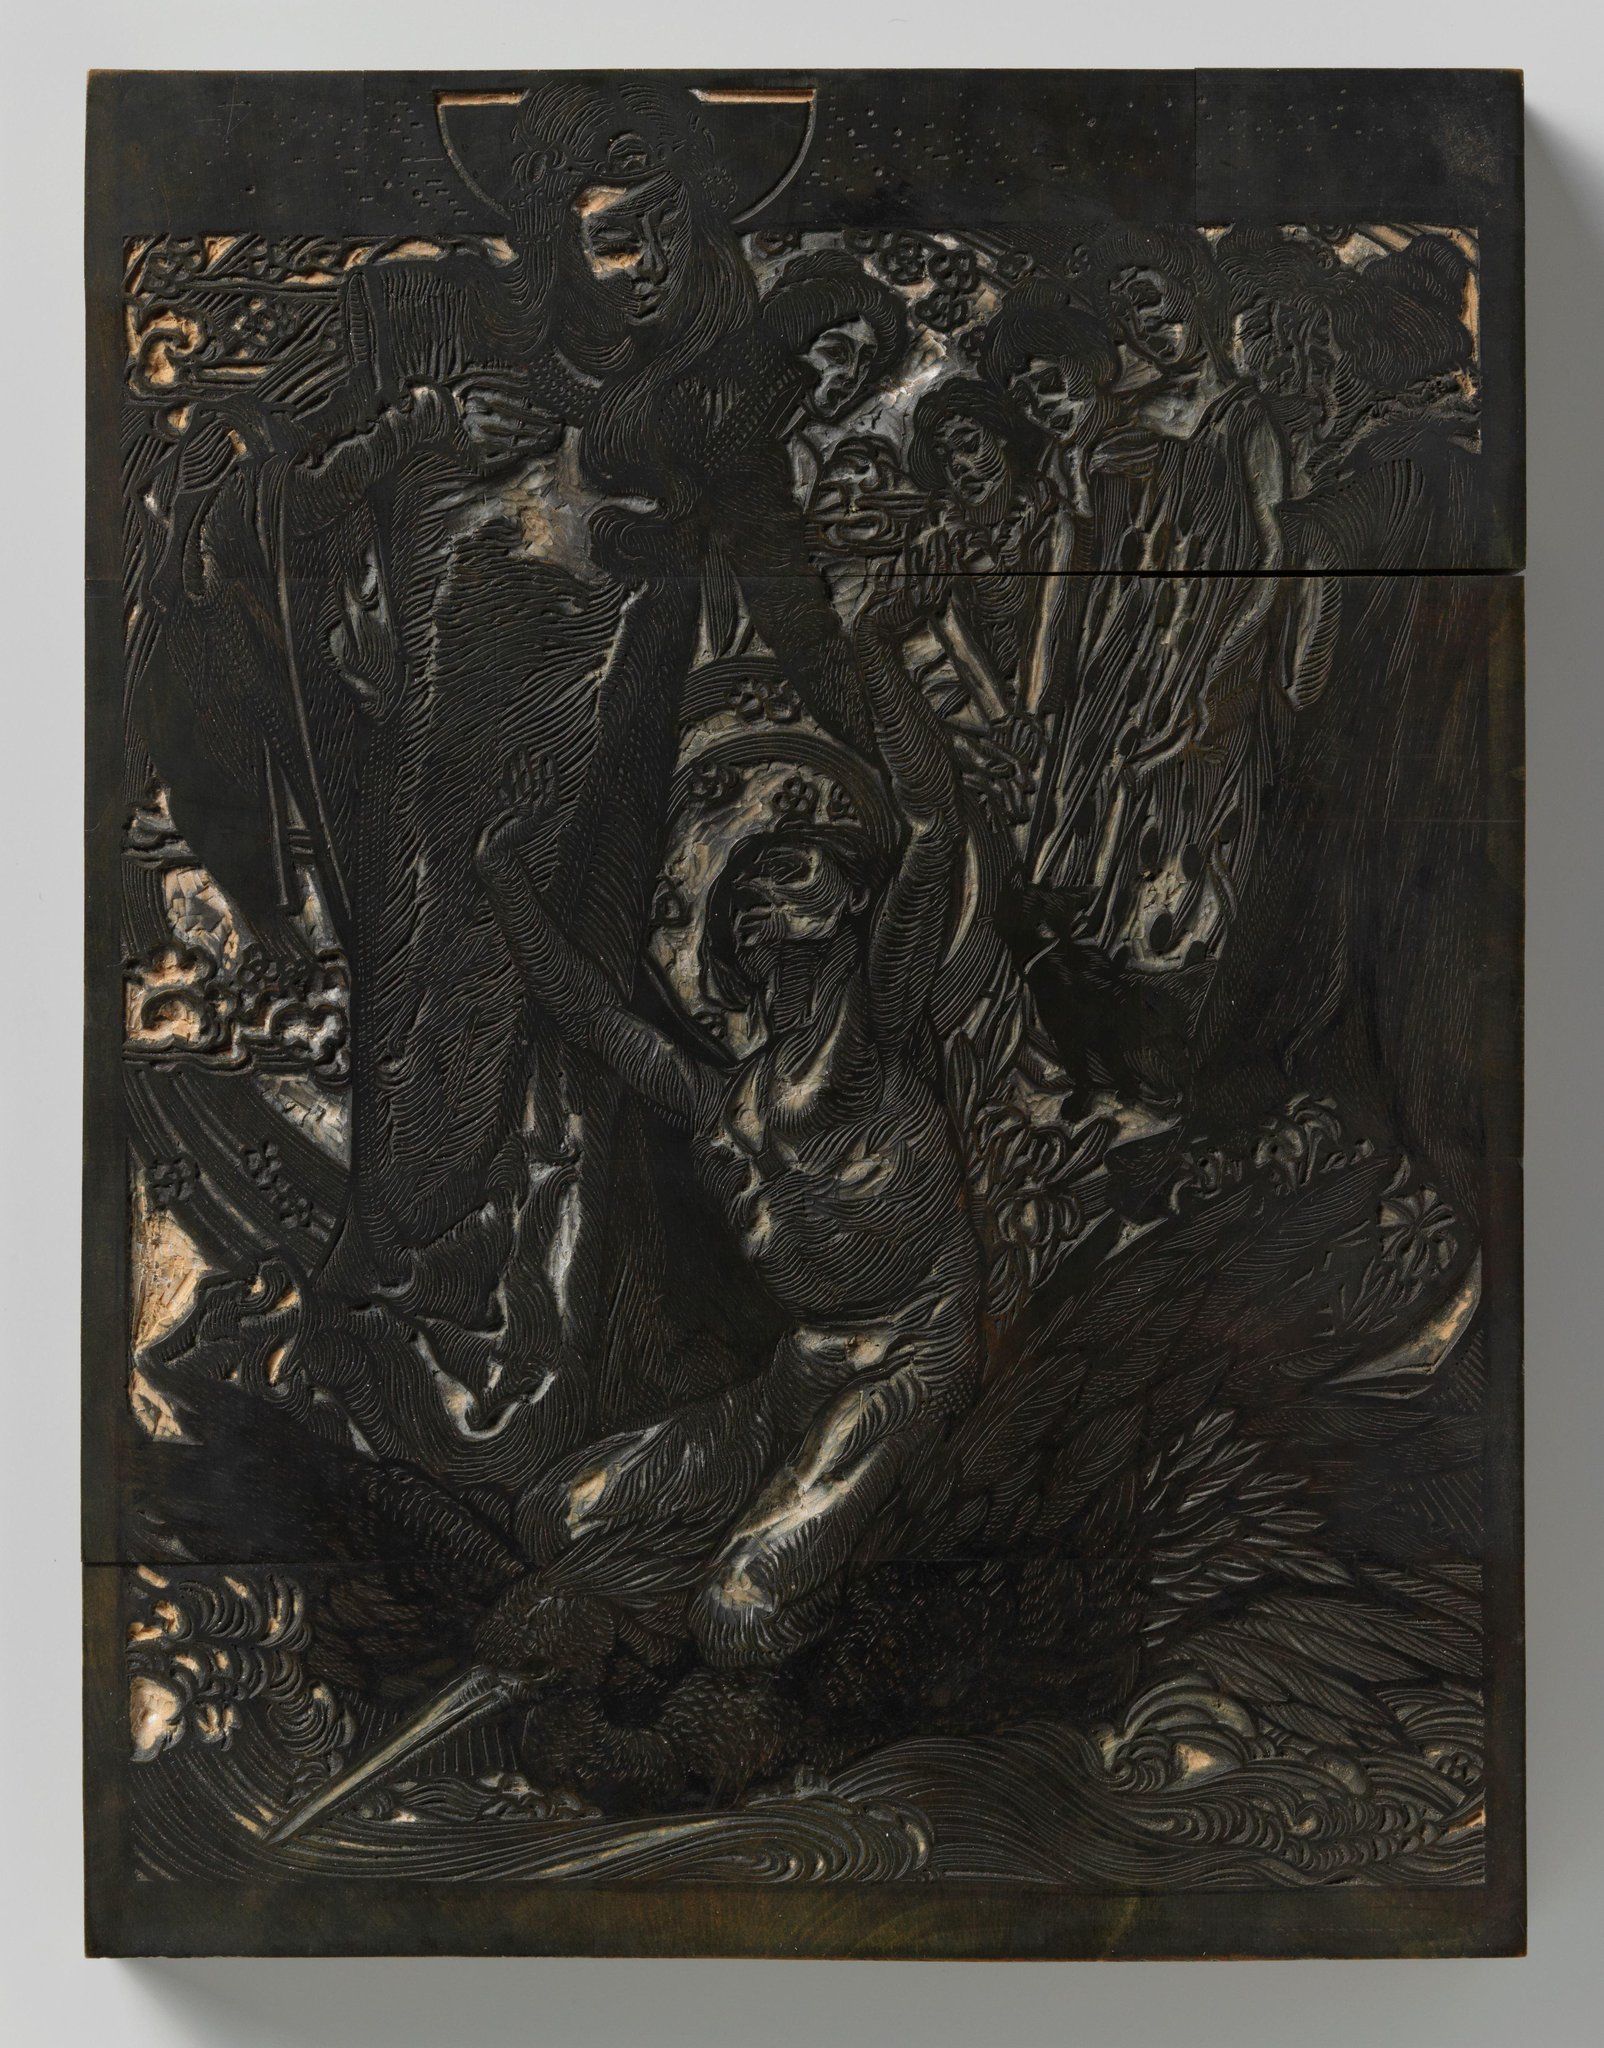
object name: houtblok kopshout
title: Compositie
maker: johannes josephus aarts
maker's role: draughtsman, print maker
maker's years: 1871-1934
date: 1881-1934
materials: wood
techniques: woodcut